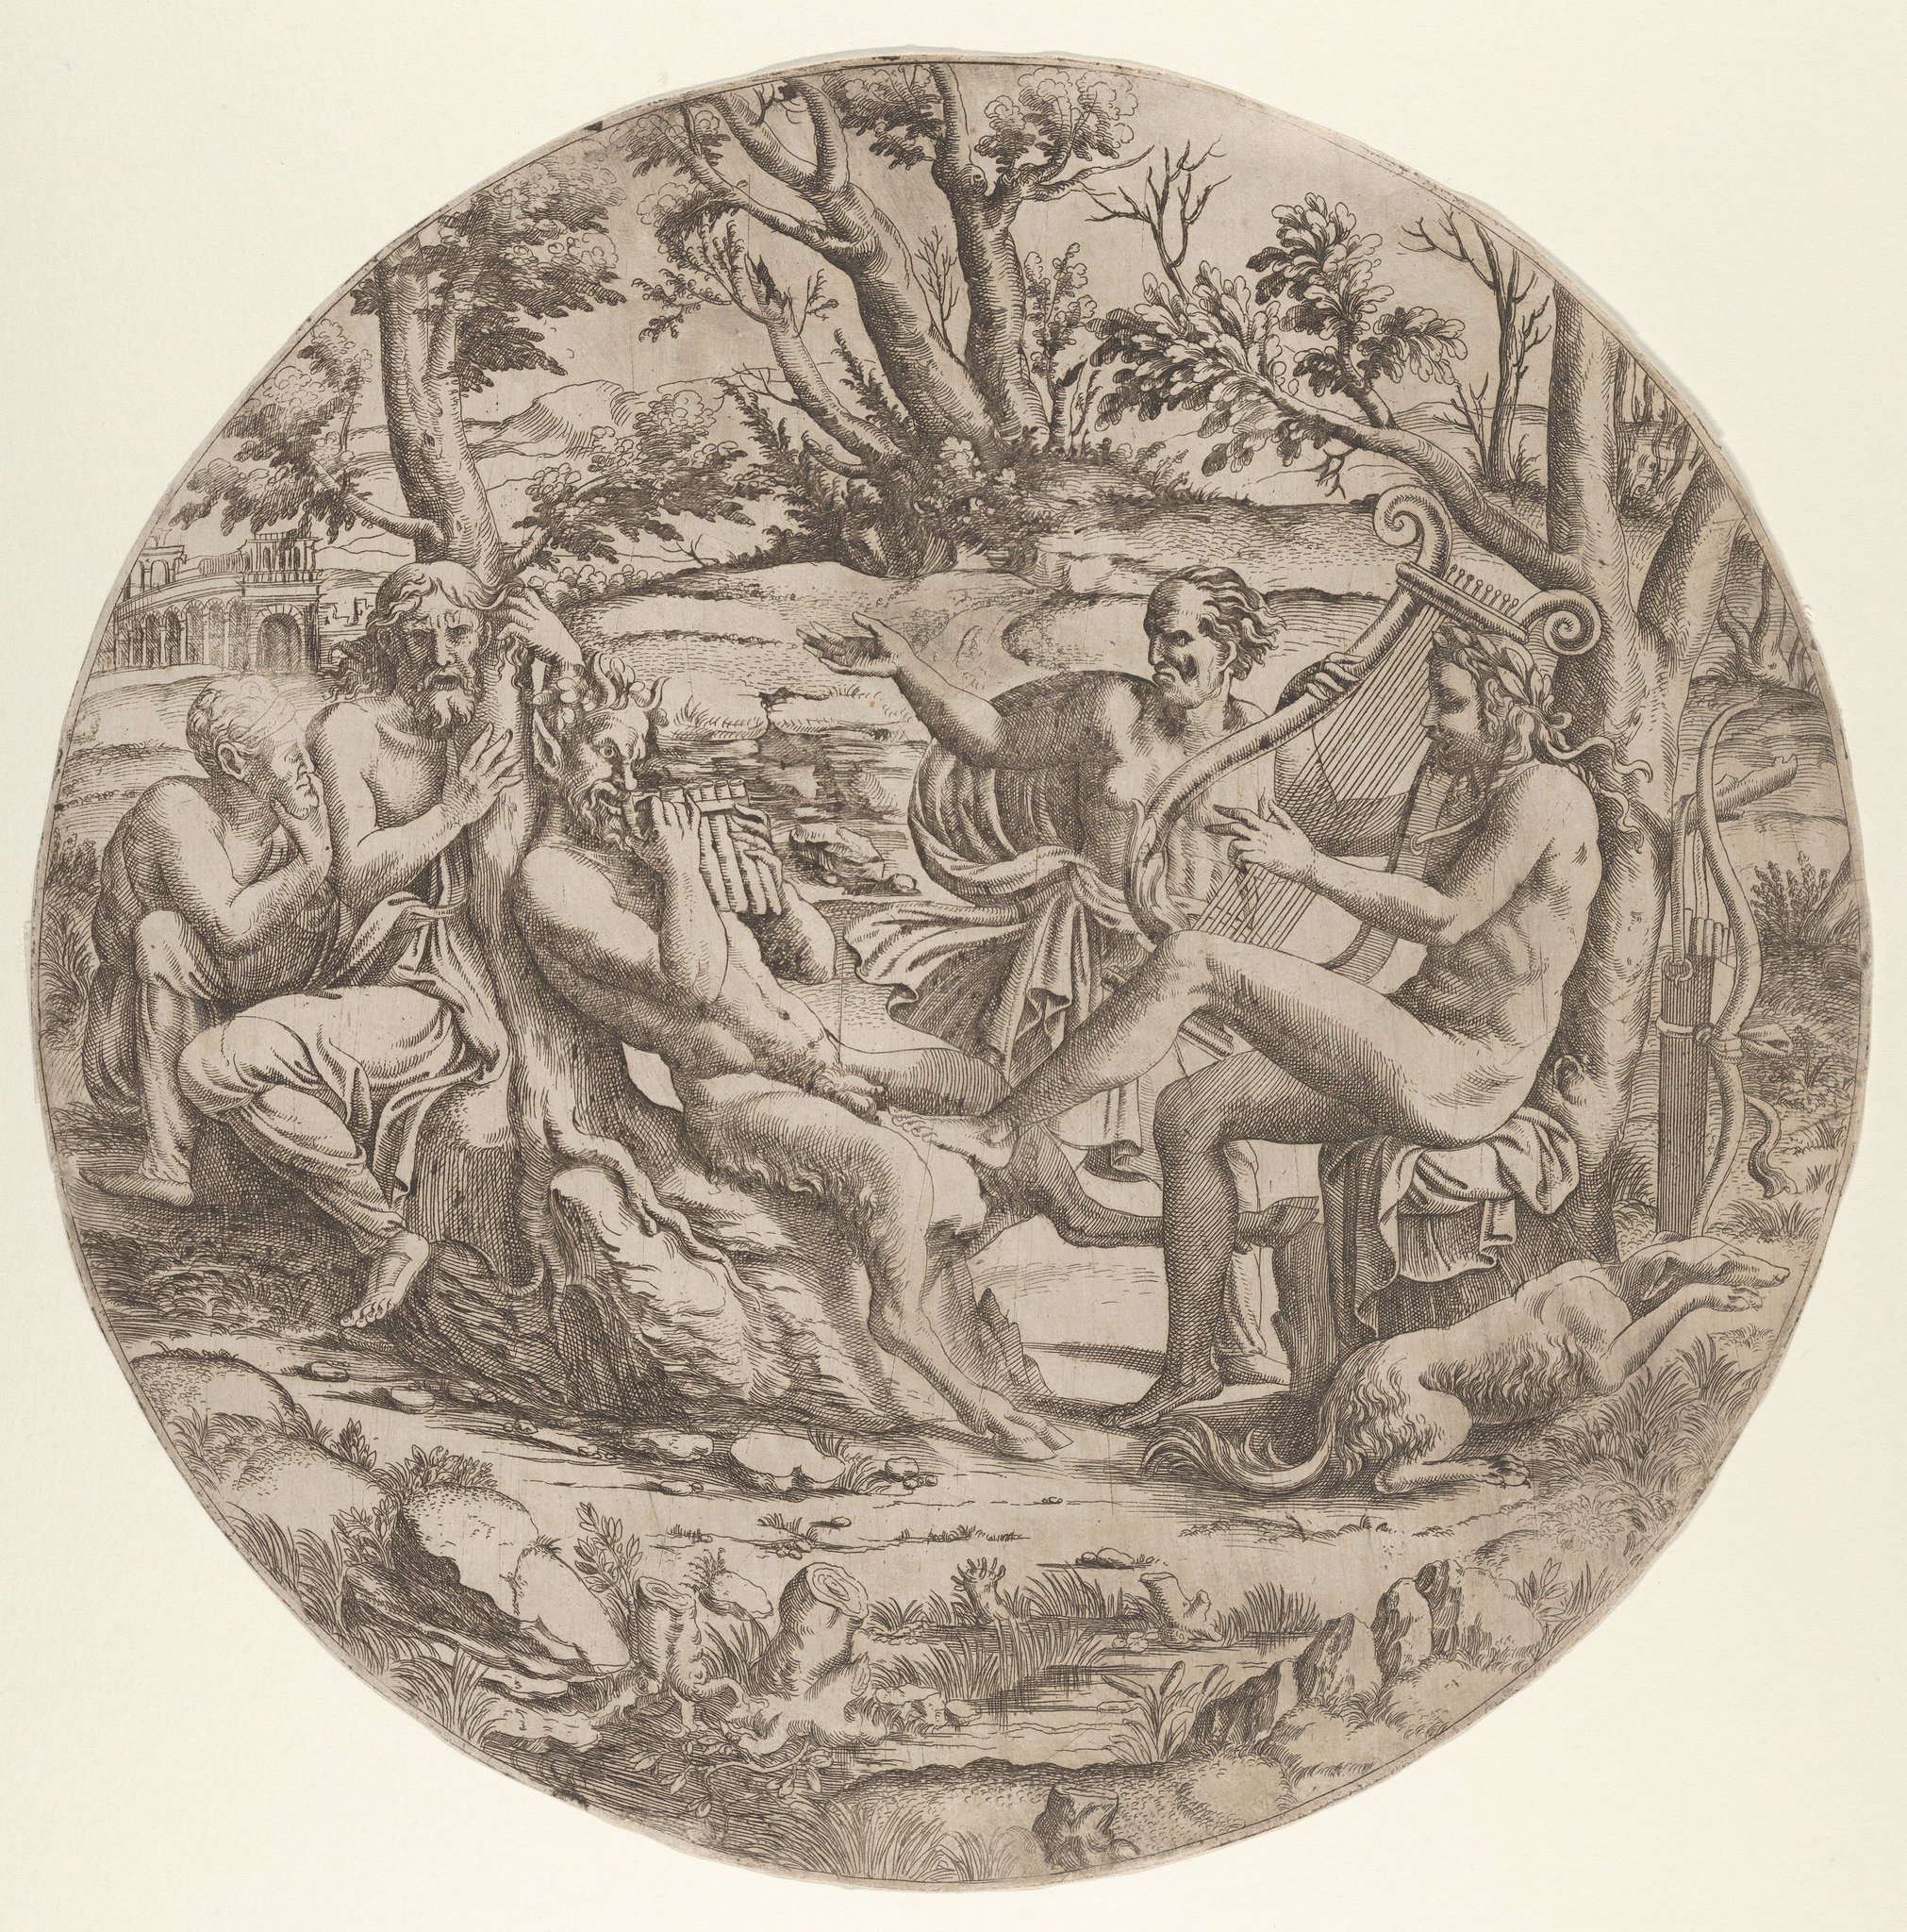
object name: print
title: Contest between Apollo and Marsyas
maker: anonymous, french, school of fontainebleau, 16th century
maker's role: artist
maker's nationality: french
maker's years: 1500-1600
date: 1543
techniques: etching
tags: musical instruments,bow and arrow,men,music,apollo,dogs,trees